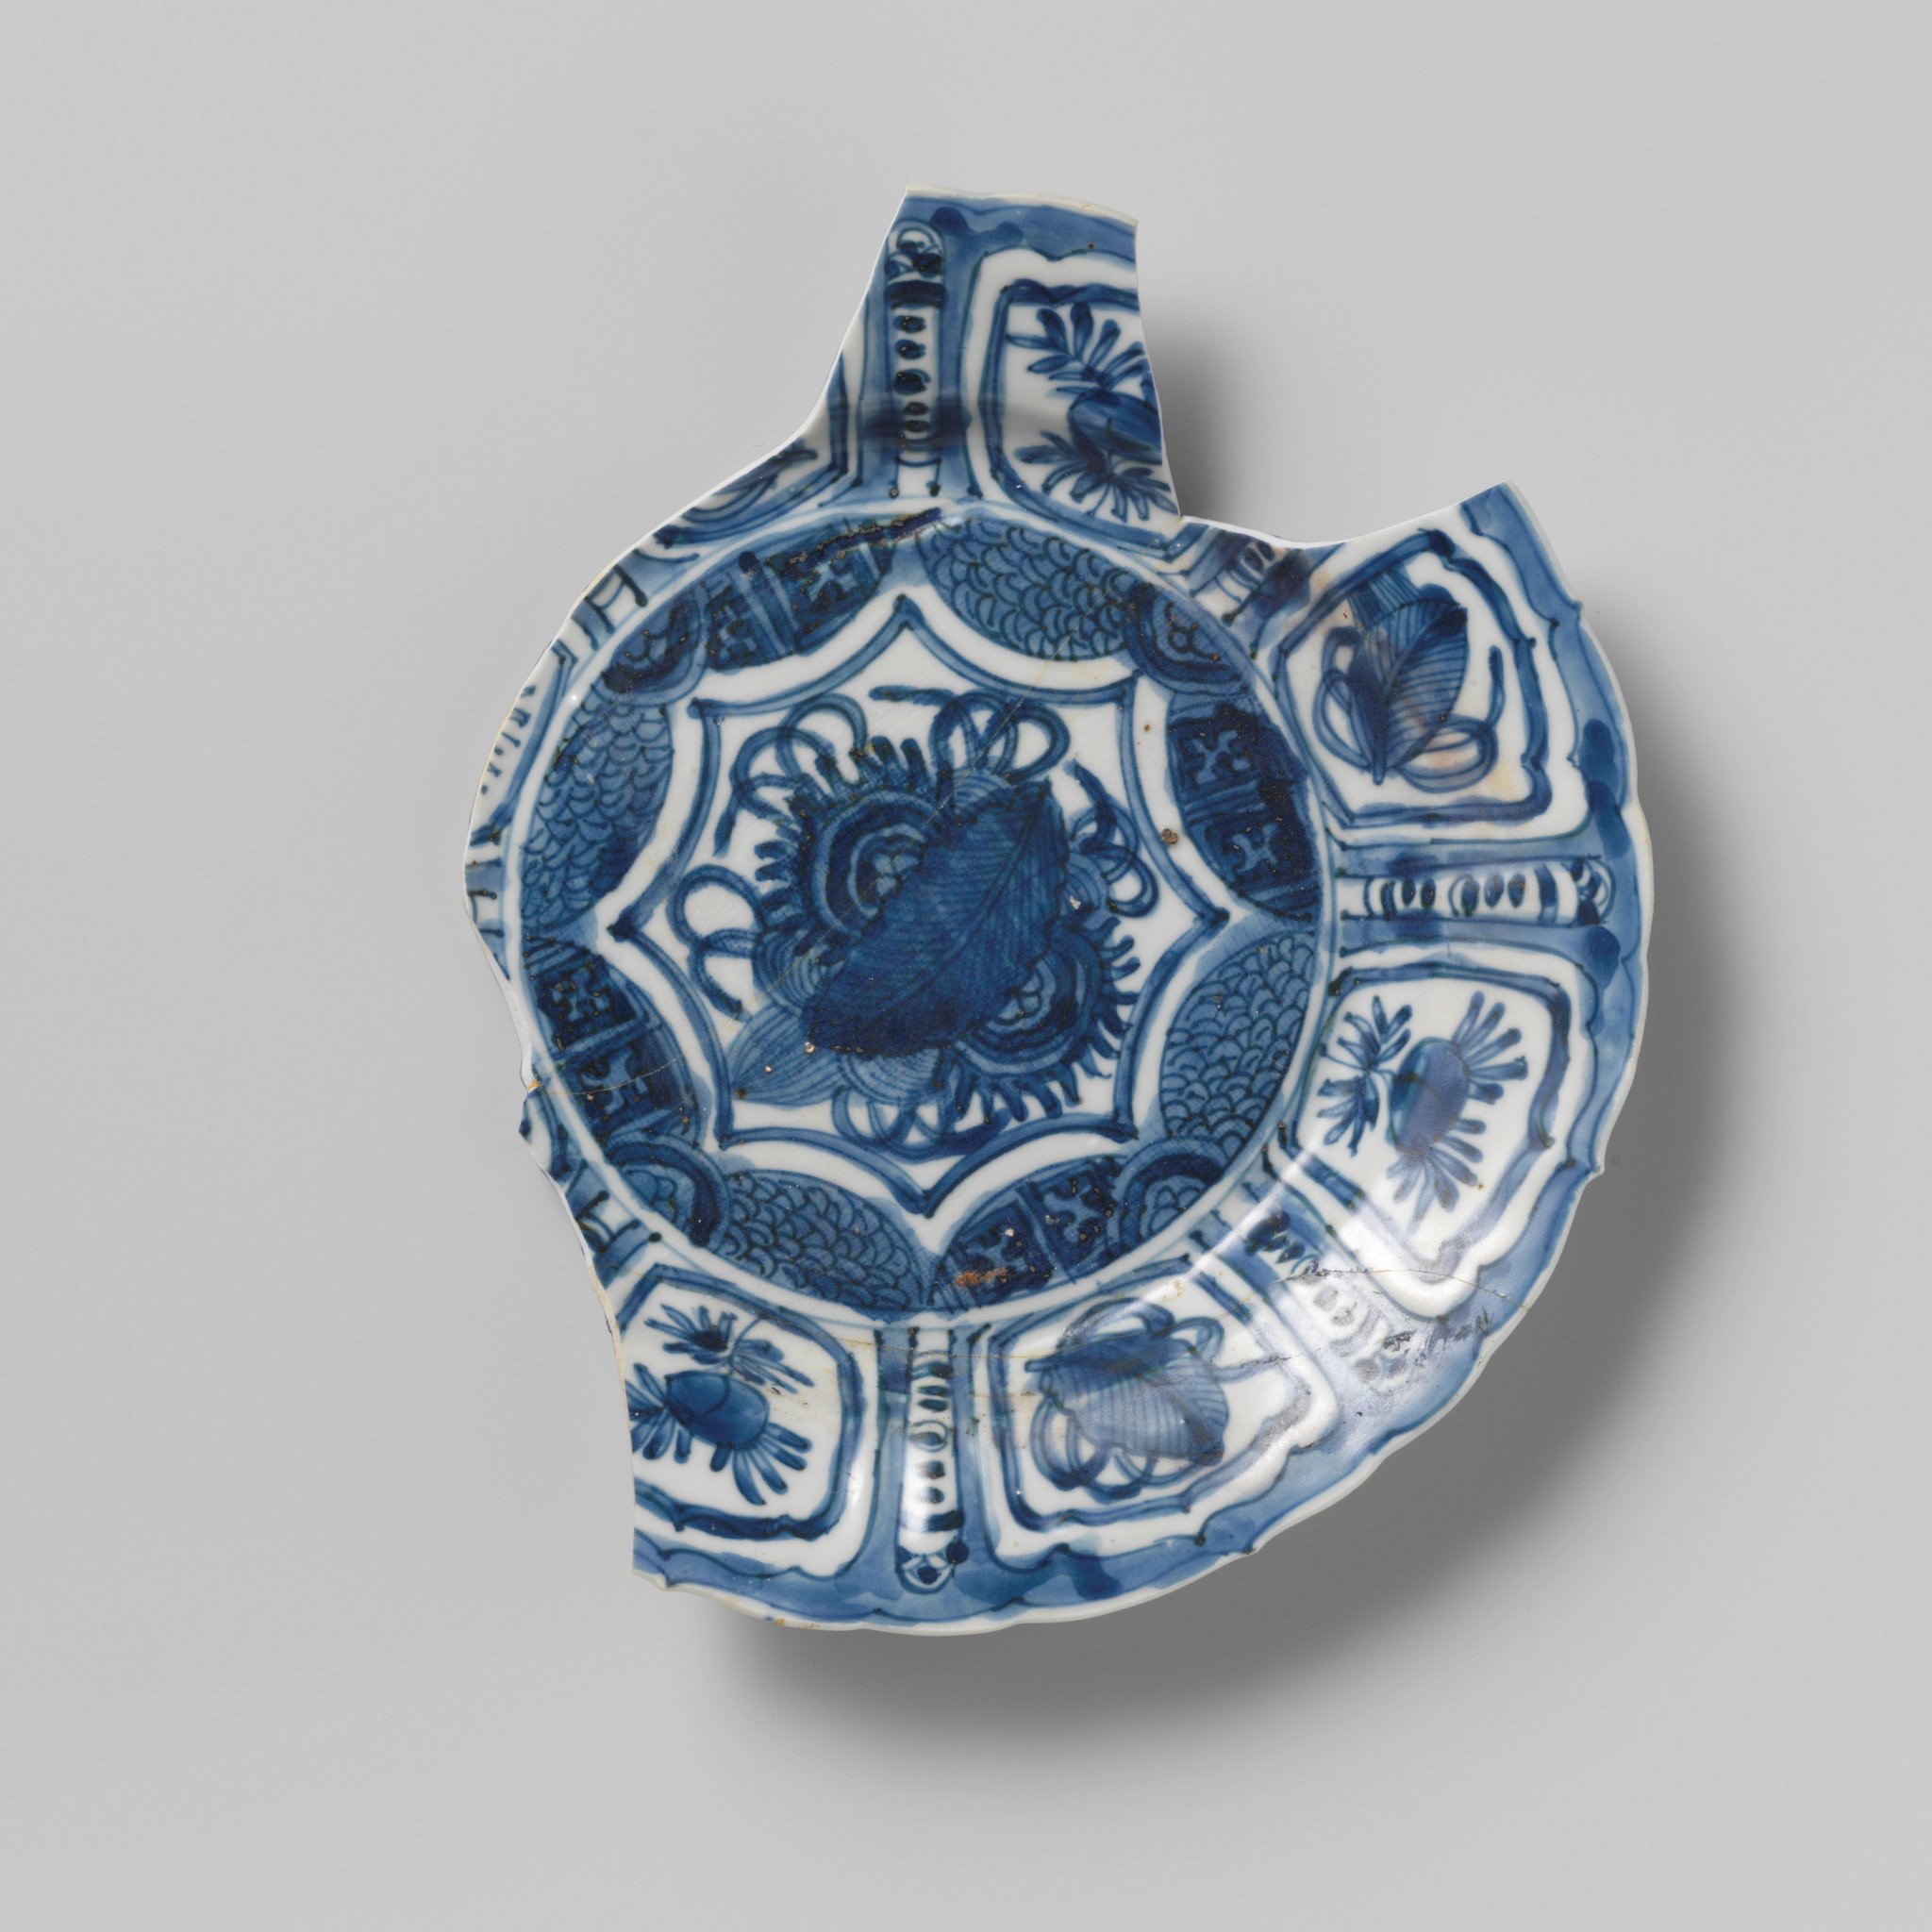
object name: plate dish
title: Fragment bord uit V.O.C.-schip de 'Witte Leeuw'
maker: Anonymous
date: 1613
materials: bone china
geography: jingdezhen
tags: verenigde oostindische compagnie, sint-helena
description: A plate with a flattened rim. A star-shaped medallion with 4 rui heads and various diaper patterns. These plates all have a central decoration of symbols; thedecoration on cavetto and rim are also similar. Another typical feature of these plates is the pattern resemblimg the imprint of woven cloth in the centre, under the glaze. A central decoration of symbols. Panels decorated with flowers, peaches and symbols.